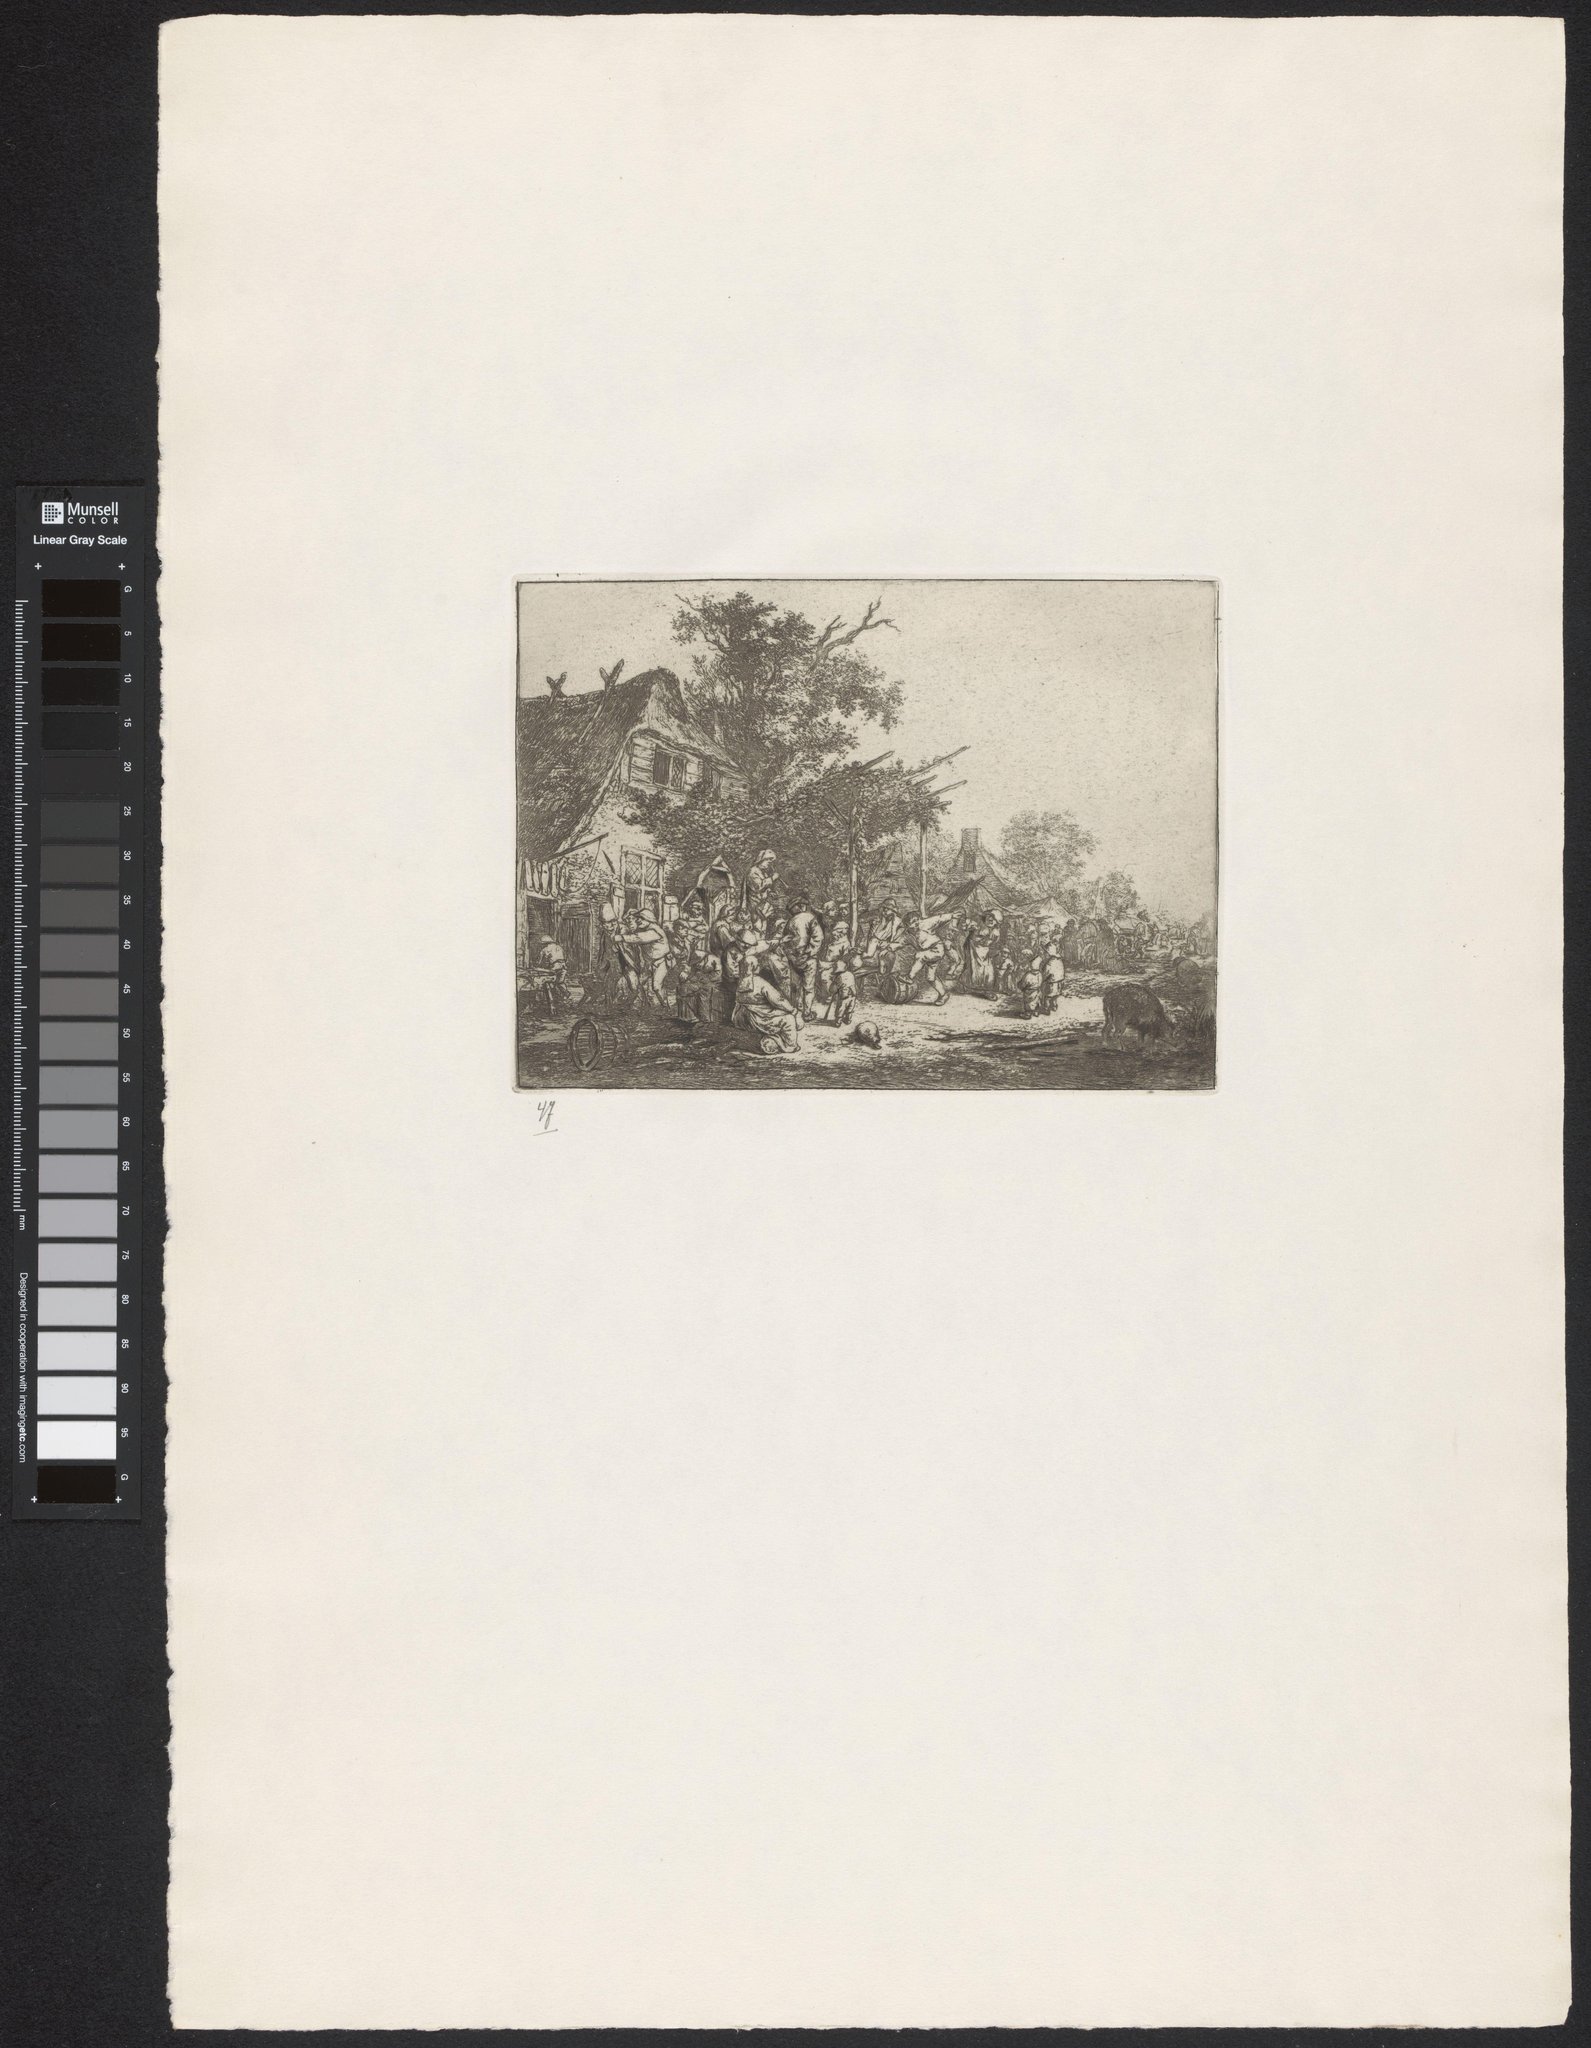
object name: print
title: Gebochelde boer leunend op een stok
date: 1668-1672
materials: paper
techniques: etching, galvanization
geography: haarlem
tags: crooked, bent person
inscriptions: collector's mark: ‘RIJKS / MUSM’, collector's mark: ‘B’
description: De prent maakt deel uit van een portefeuille en is met een andere prent op één albumblad gedrukt.